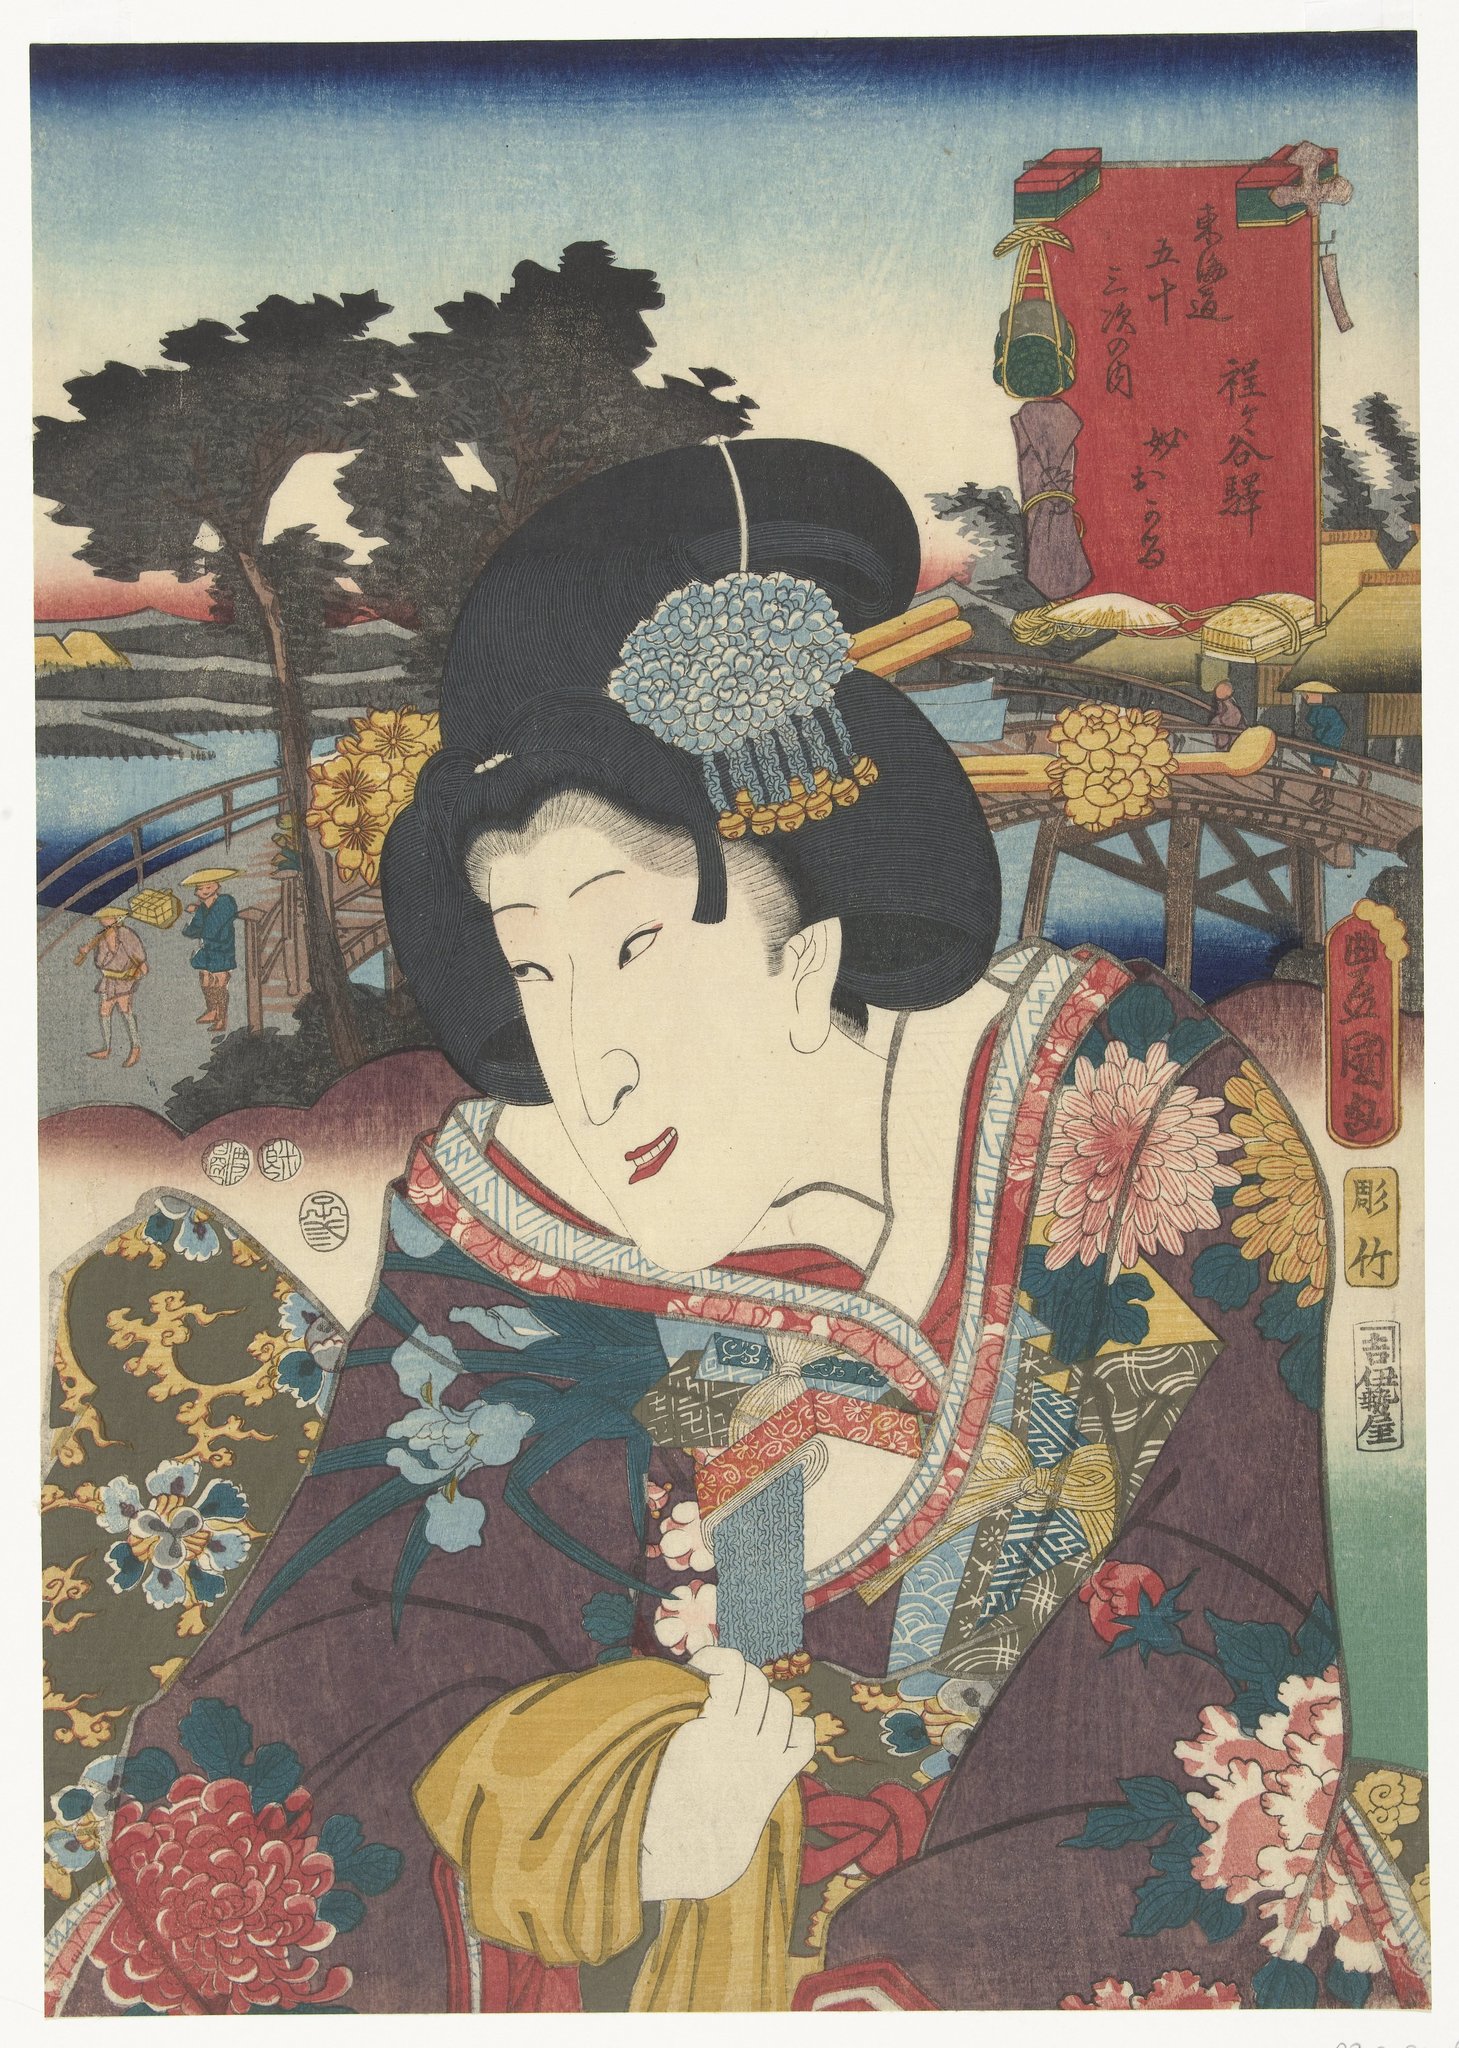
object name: print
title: Hodogaya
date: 1803-1852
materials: paper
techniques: woodcut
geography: japan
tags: actor (on the stage)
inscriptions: signature: ‘Toyokuni ga’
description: Vrouw (de acteur Bando Shuka in de vrouwenrol Okaru) in kleurige kimono met verschillende bloem patronen, opzij kijkend, tegen achtergrond met gezicht op de pleisterplaats Hodogaya; reizigers op brug over rivier met huizen langs de oever.